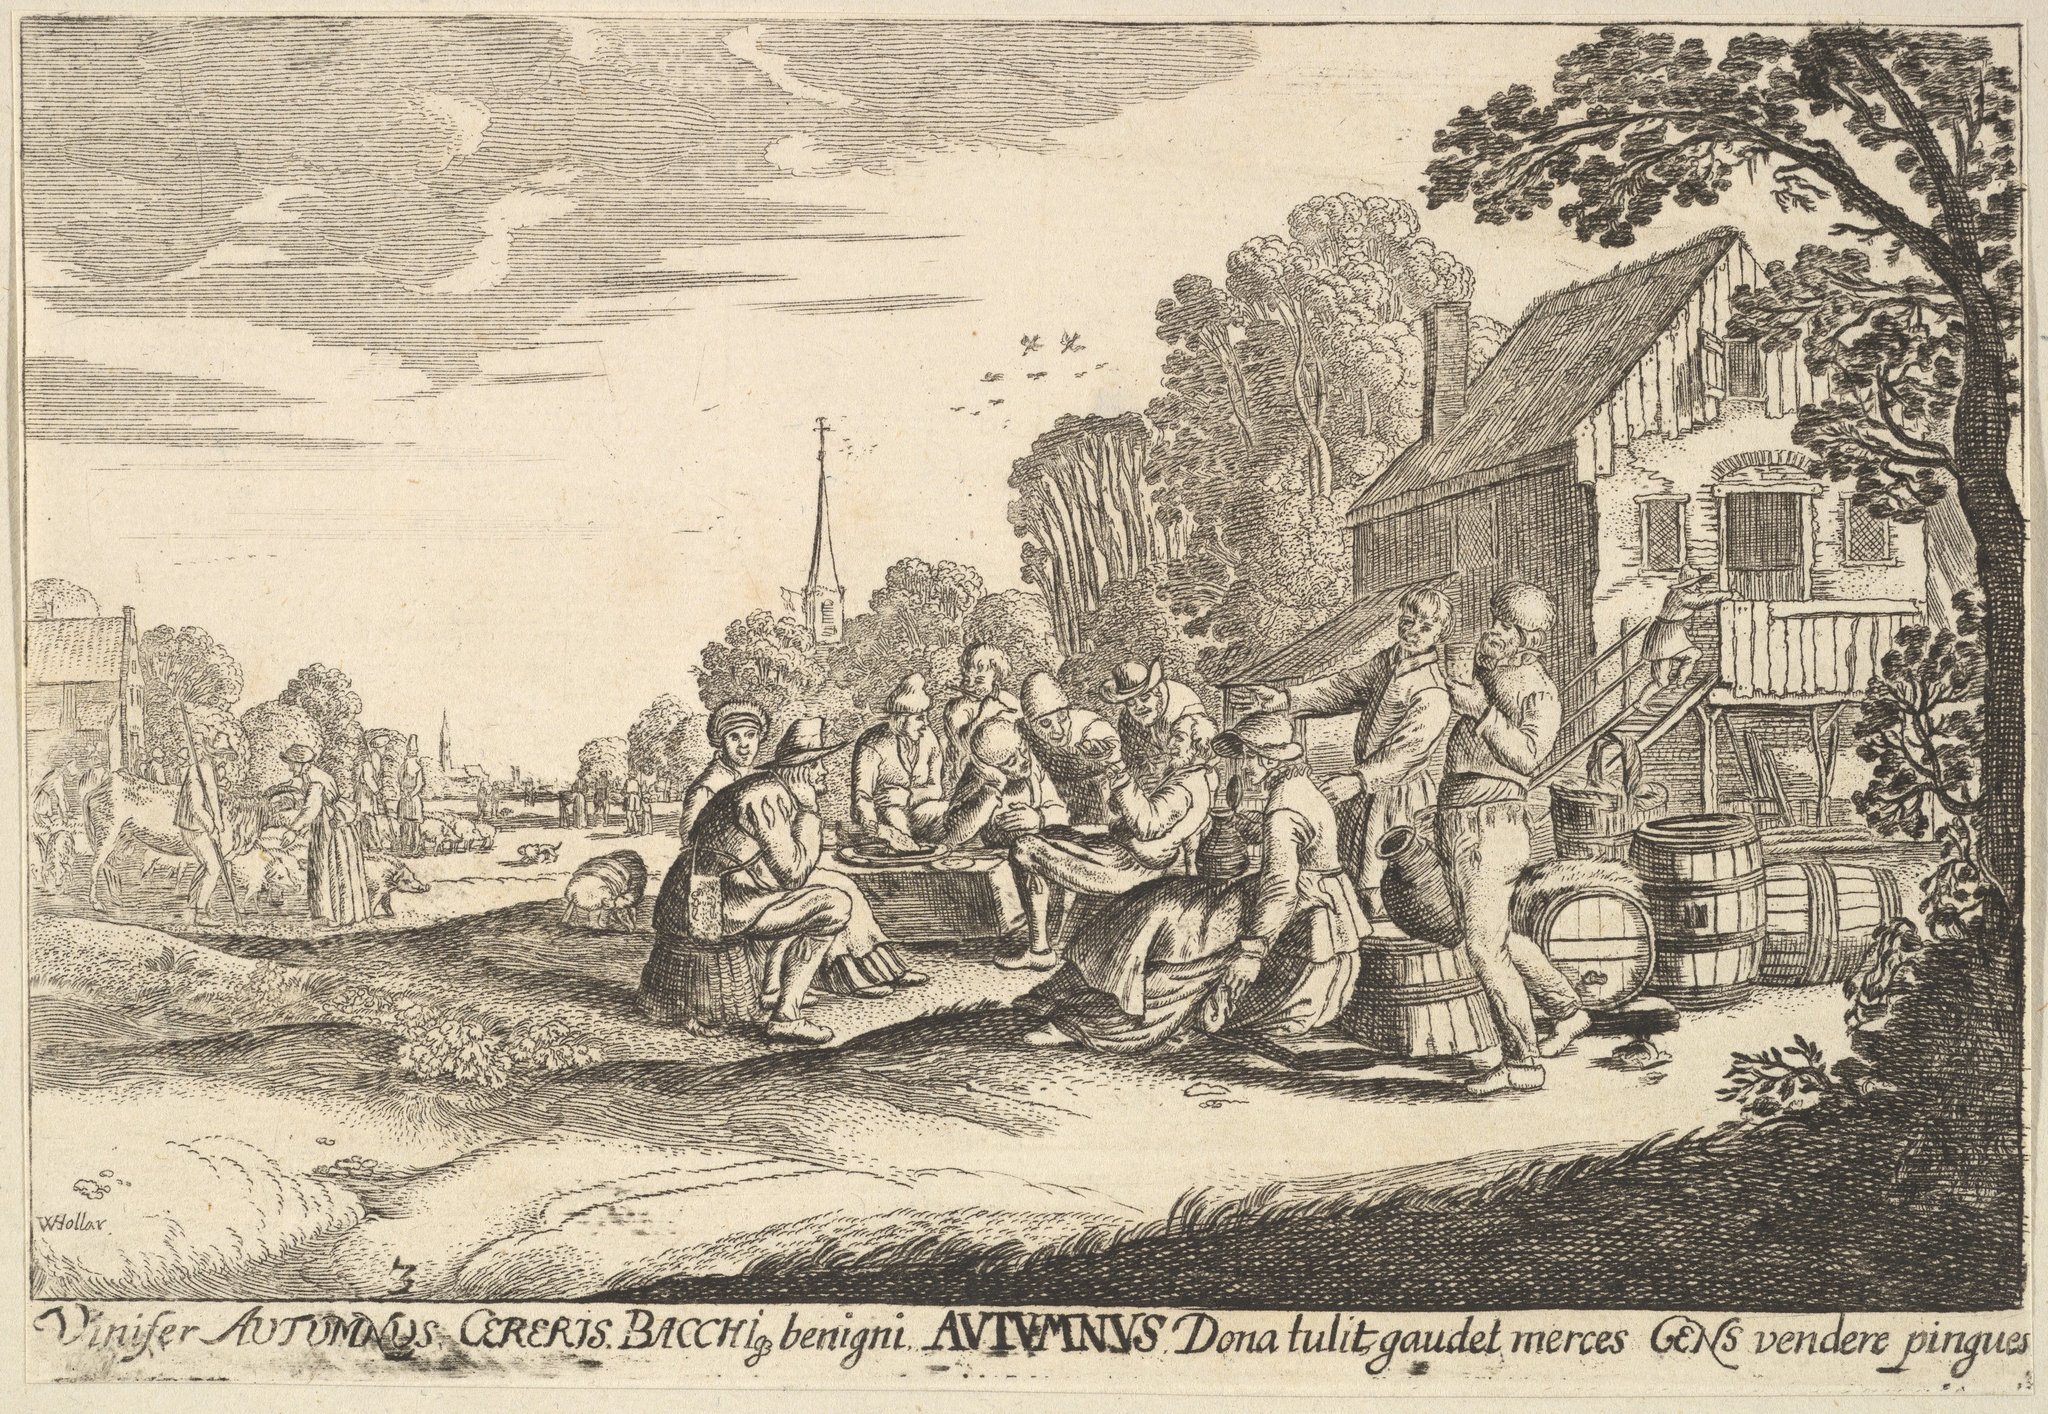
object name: print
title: Autumn (Autumness)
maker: wenceslaus hollar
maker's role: artist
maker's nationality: bohemian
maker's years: 1607-1677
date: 1629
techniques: etching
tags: houses,men,women,autumn,genre scene